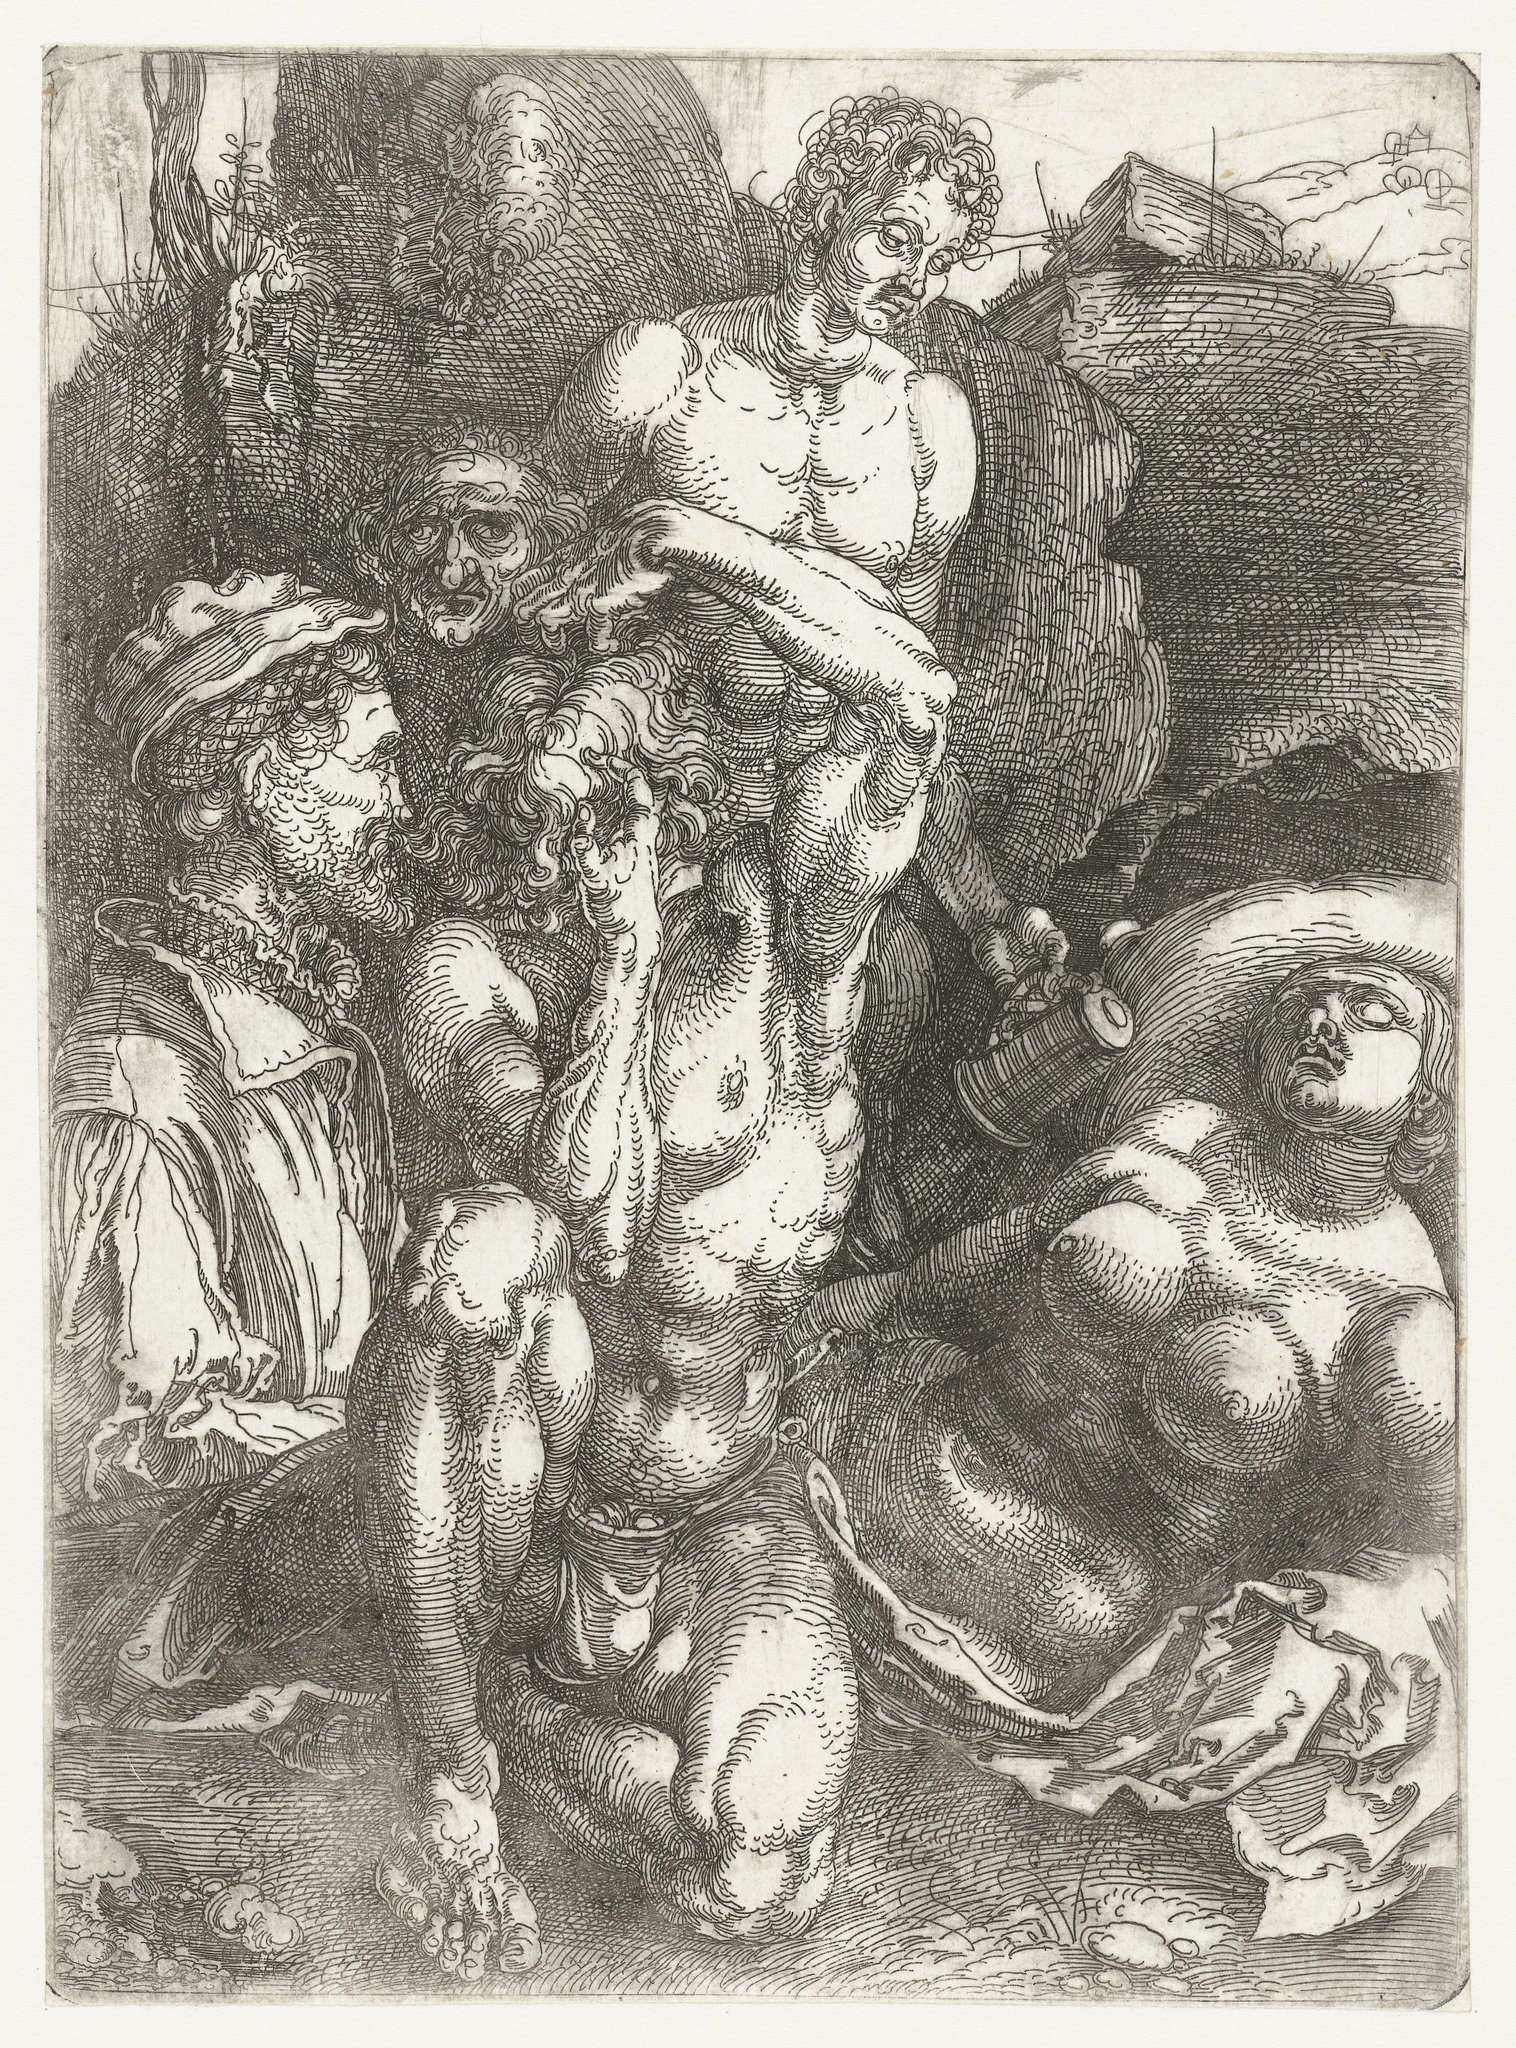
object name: print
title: Studieblad met vijf figuren ('De wanhopige man')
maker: albrecht dürer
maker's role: draughtsman, painter, print maker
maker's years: 1471-1528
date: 1513-1517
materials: paper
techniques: etching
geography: nuremberg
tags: the (nude) human figure; 'corpo humano' (ripa) (+ despairing), despair; 'disperatione' (ripa), sleeping; unconsciousness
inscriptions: collector's mark: Lugt 2228a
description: Een man met de handen in het haar, een slapende naakte vrouw, een man met een drinkkan, een gezicht van een oude man, en een man met een hoed en een baard.